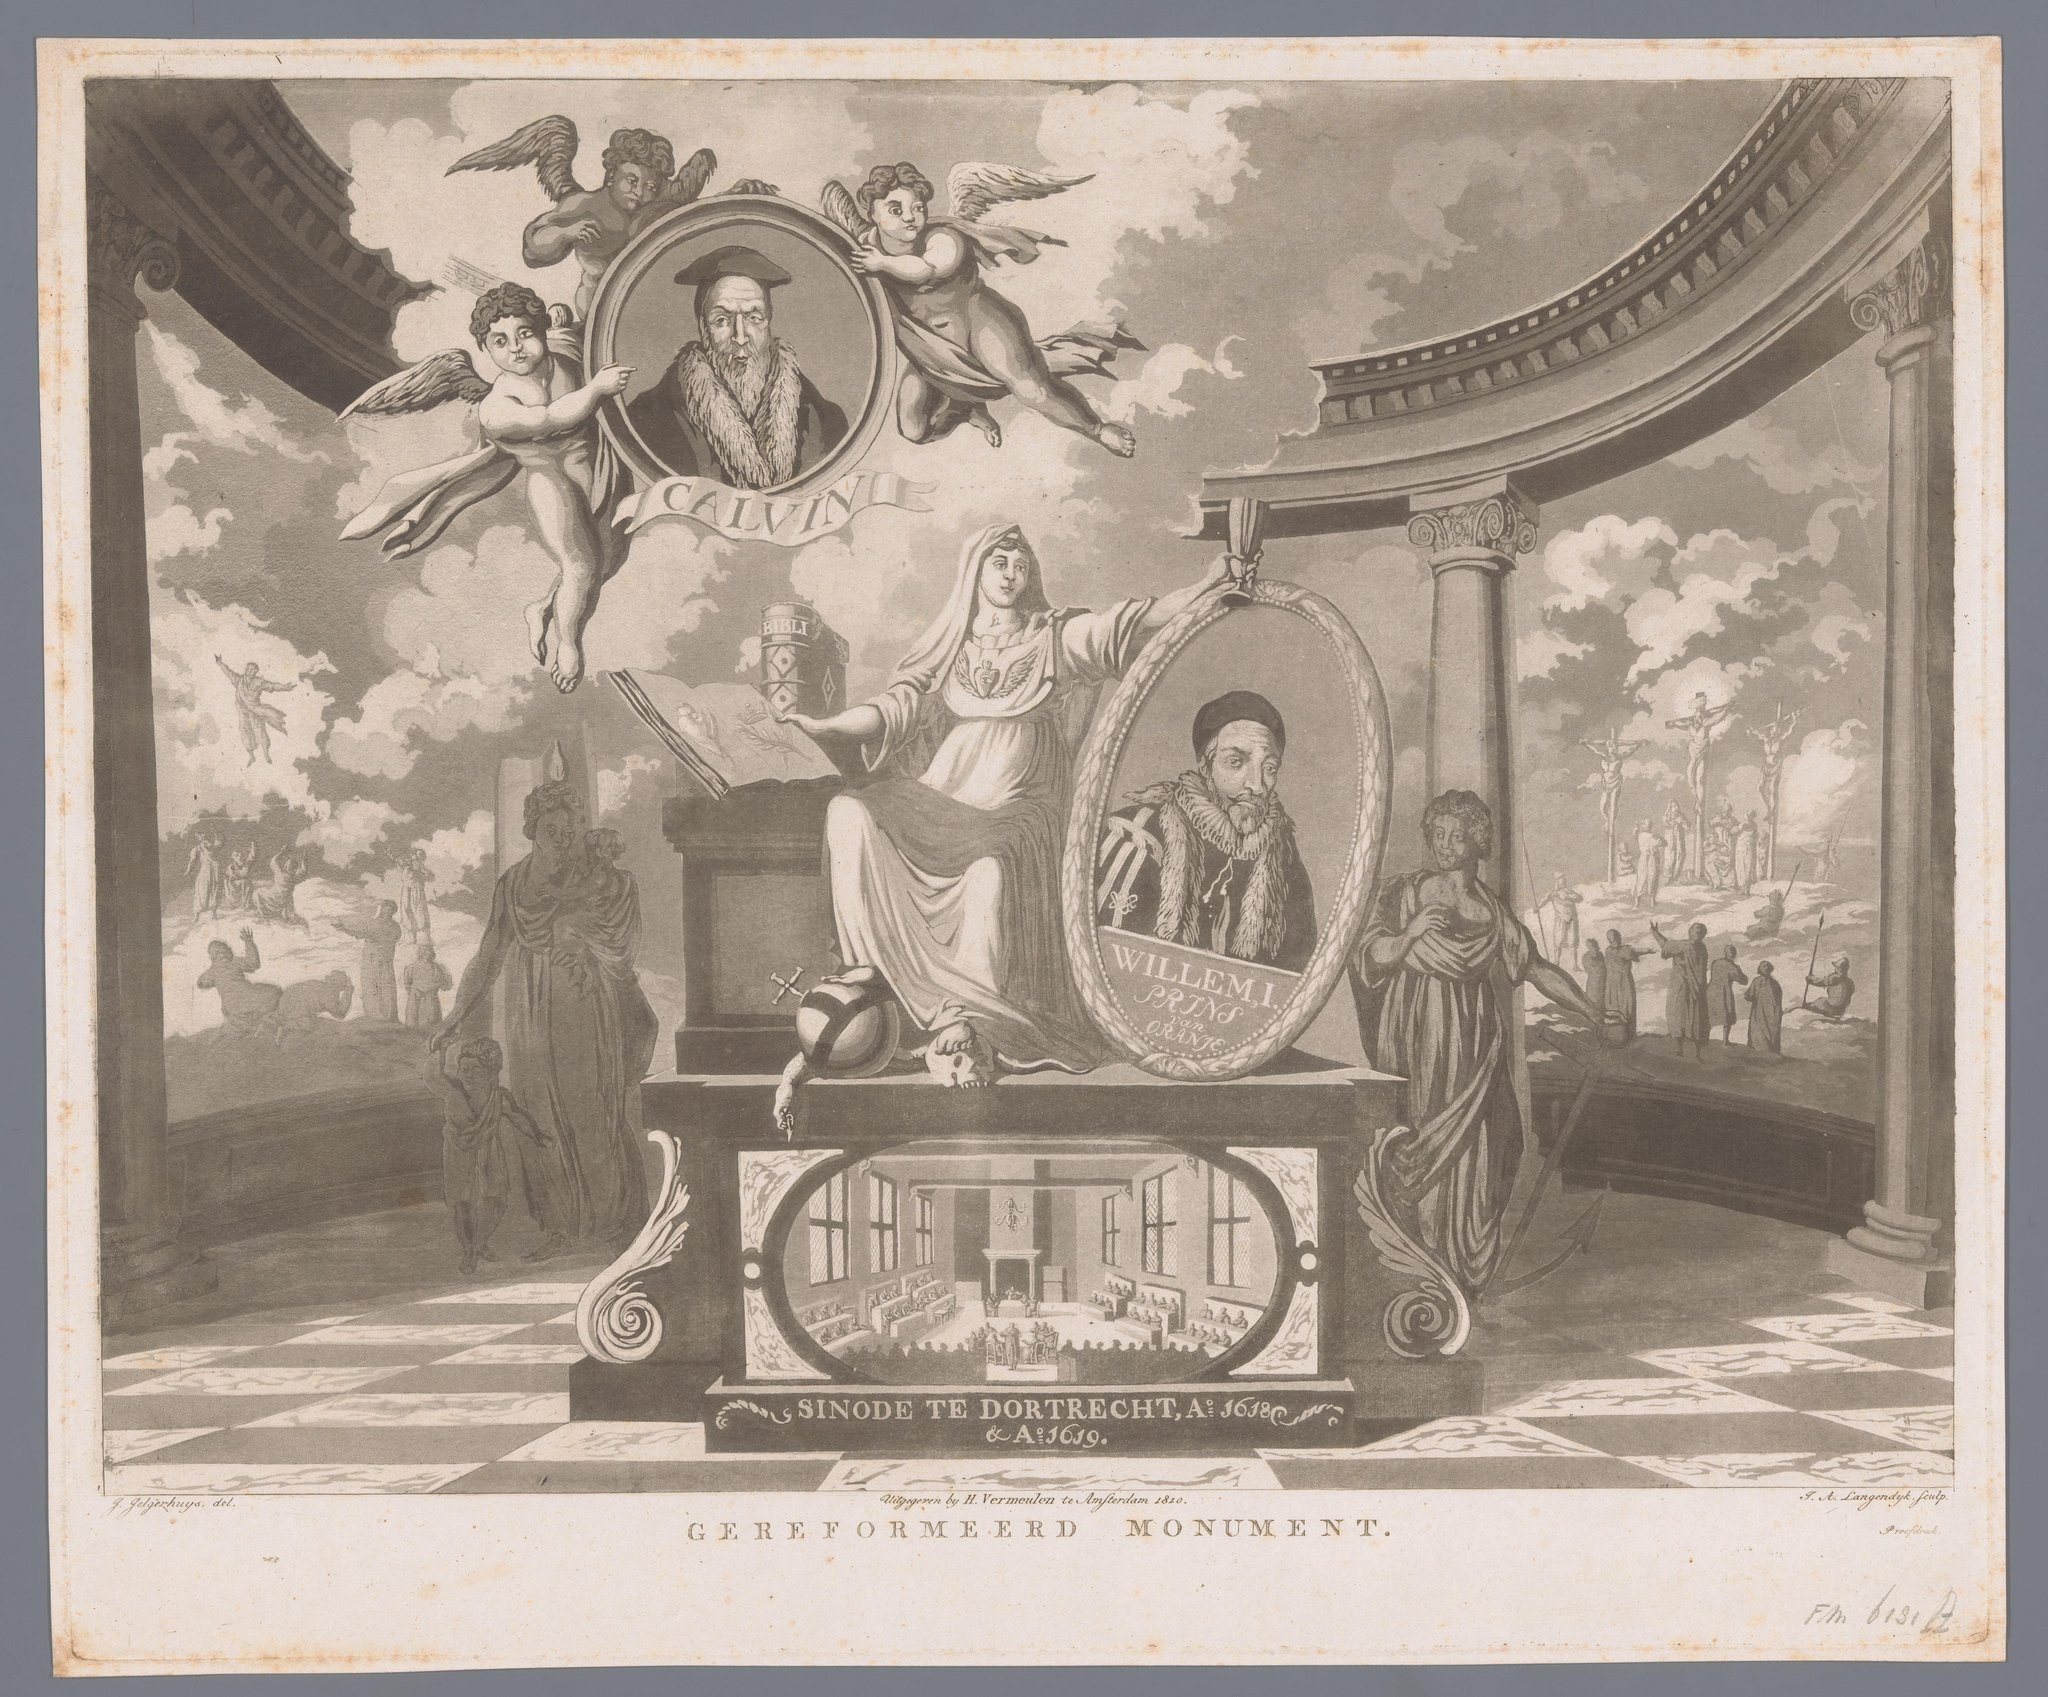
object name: print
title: Monument op tweede eeuwfeest van de Dordtse synode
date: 1820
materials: paper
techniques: aquatint, engraving, etching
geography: amsterdam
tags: william i (prince of orange), organizations, assemblies, etc. in protestant churches, hope, 'spes'; 'speranza divina e certa' (ripa) ~ one of the three theological virtues, christ ascends into heaven; apostles (and mary) beneath, the crucifixion of christ: christ's death on the cross; golgotha (matthew 27:45-58; mark 15:33-45; luke 23:44-52; john 19:25-38), dordrecht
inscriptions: date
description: Allegorisch monument ter ere van het tweede eeuwfeest in 1818-1819 van de nationale synode van de gereformeerde kerk gehouden te Dordrecht van 13 november 1618 tot 29 mei 1619. Centraal in een ronde tempel zit de Godsdienst op een voetstuk waarop een afbeelding van de synode. Haar linkerhand rust op een ovaal portret van Willem van Oranje. Links de Liefde, rechts de Hoop. In de wolken dragen engelen een portret van Johannes Calvijn. Op de achtergrond scènes van de hemelvaart en de kruisiging van Christus.